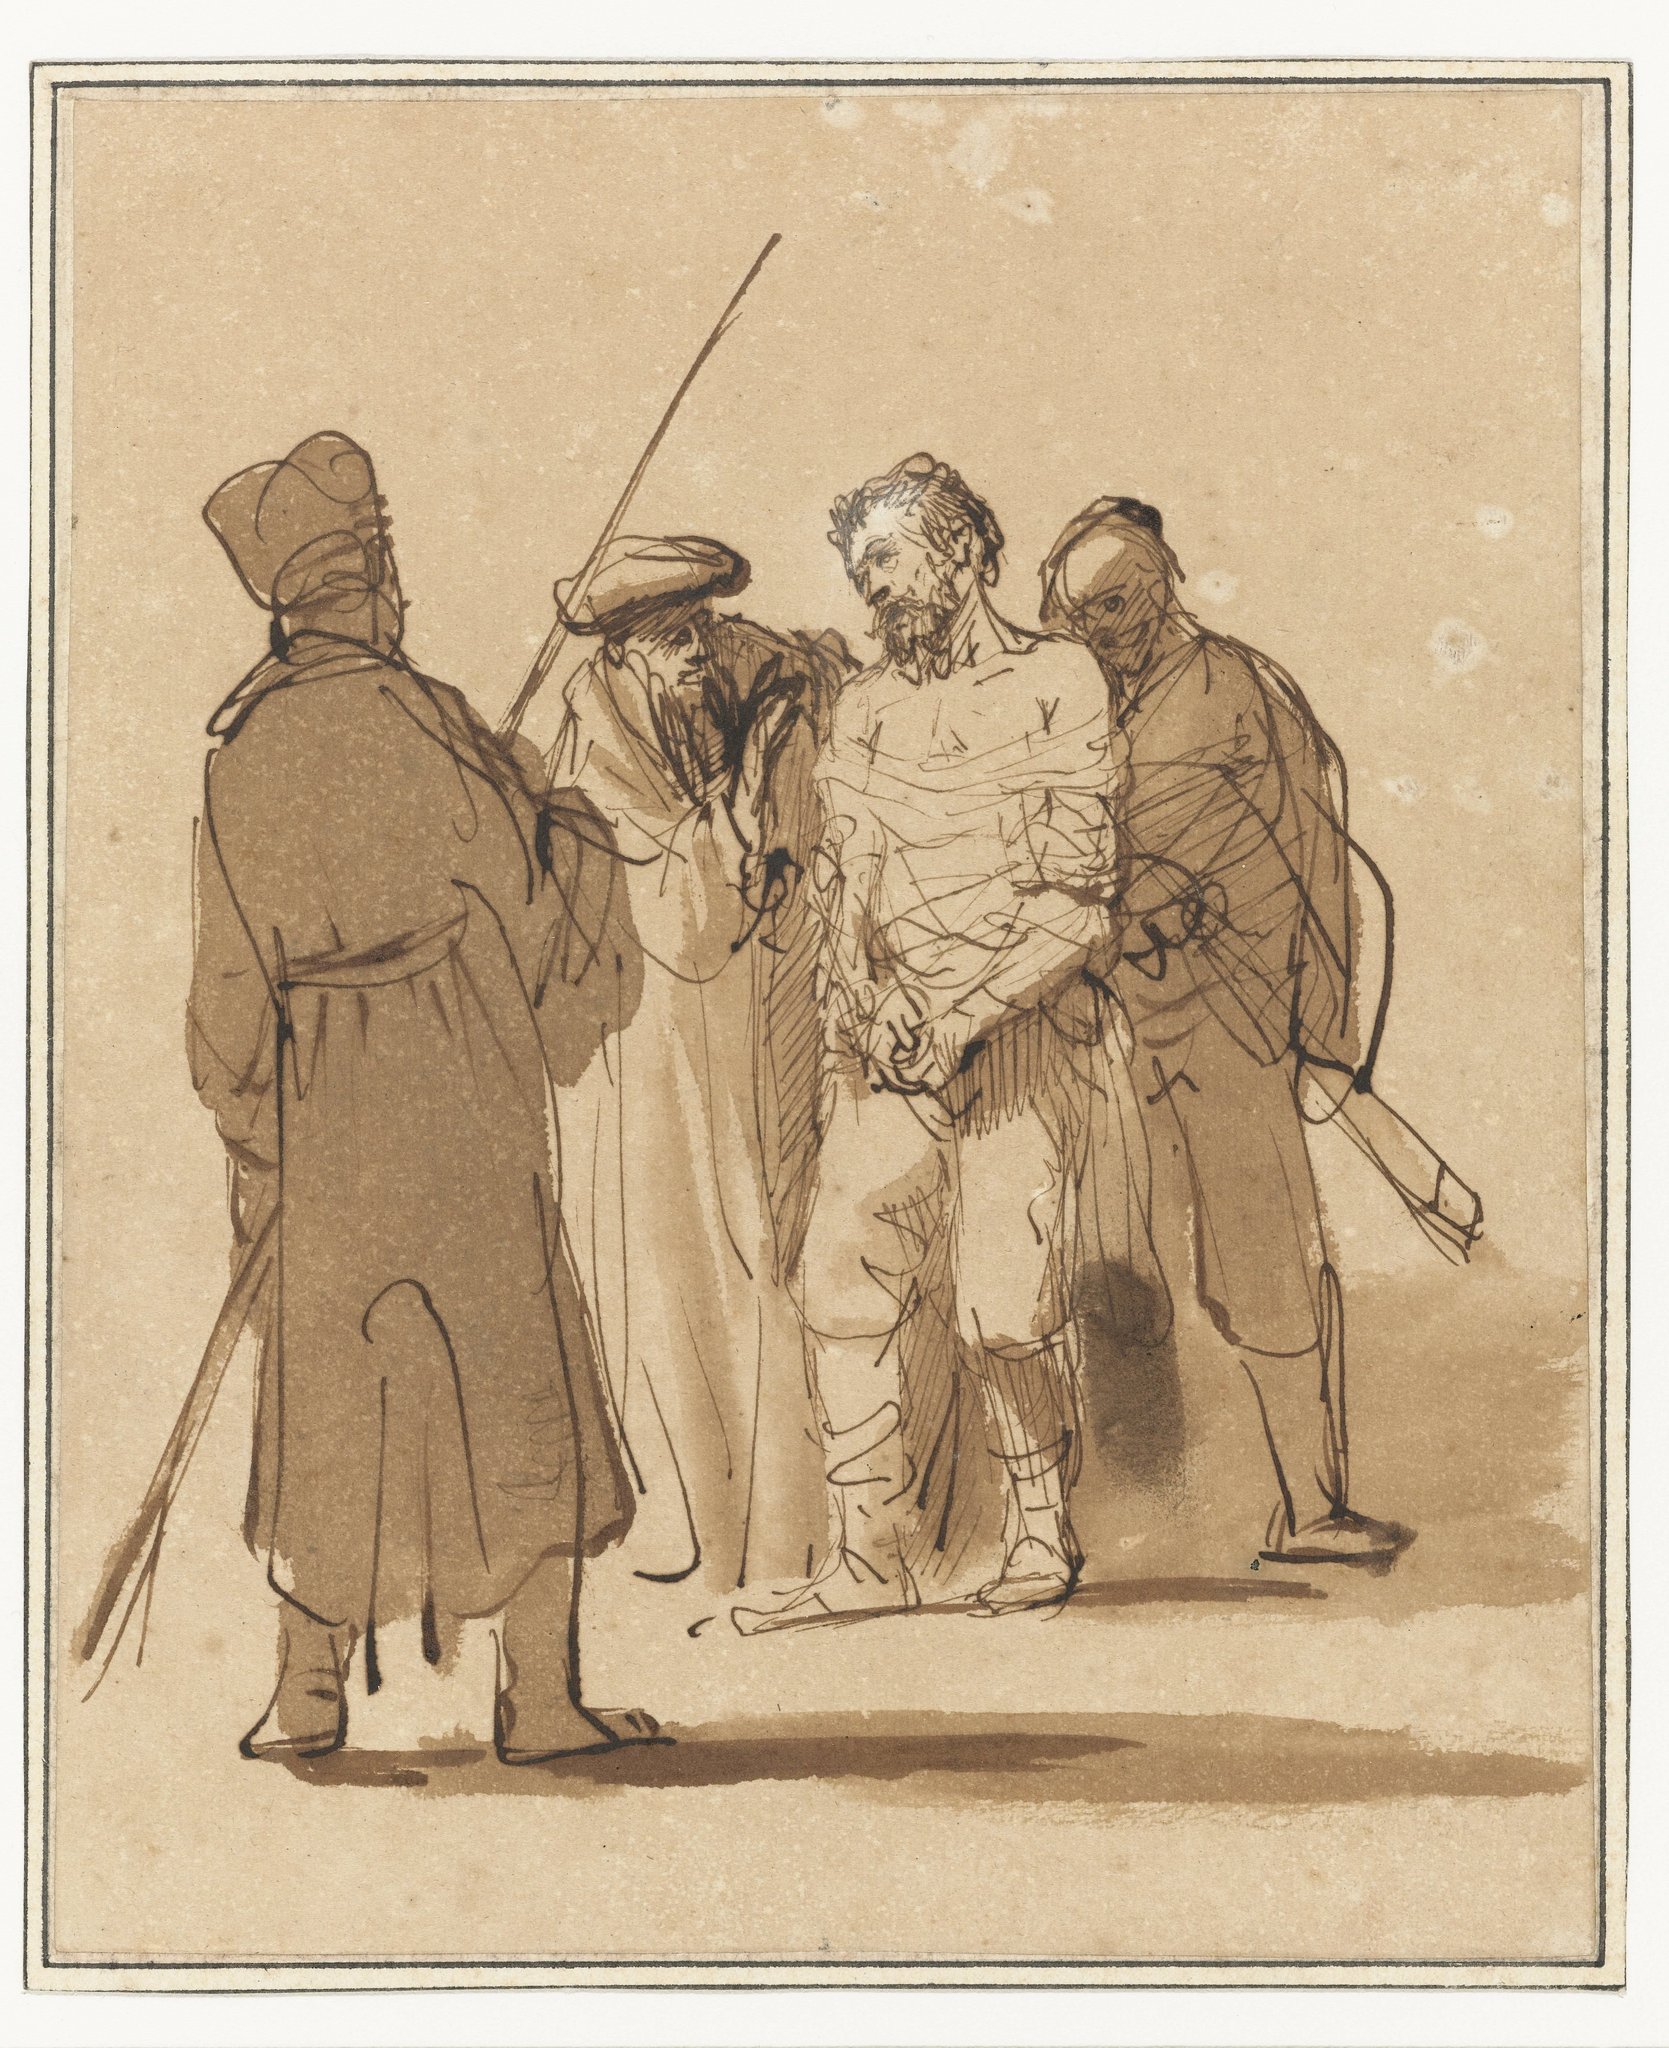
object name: drawing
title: Christ Bound between Two Soldiers and a High Priest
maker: gerbrand van den eeckhout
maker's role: draughtsman, print maker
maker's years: 1621-1674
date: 1638-1642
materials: paint, ink, paper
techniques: brush, pen